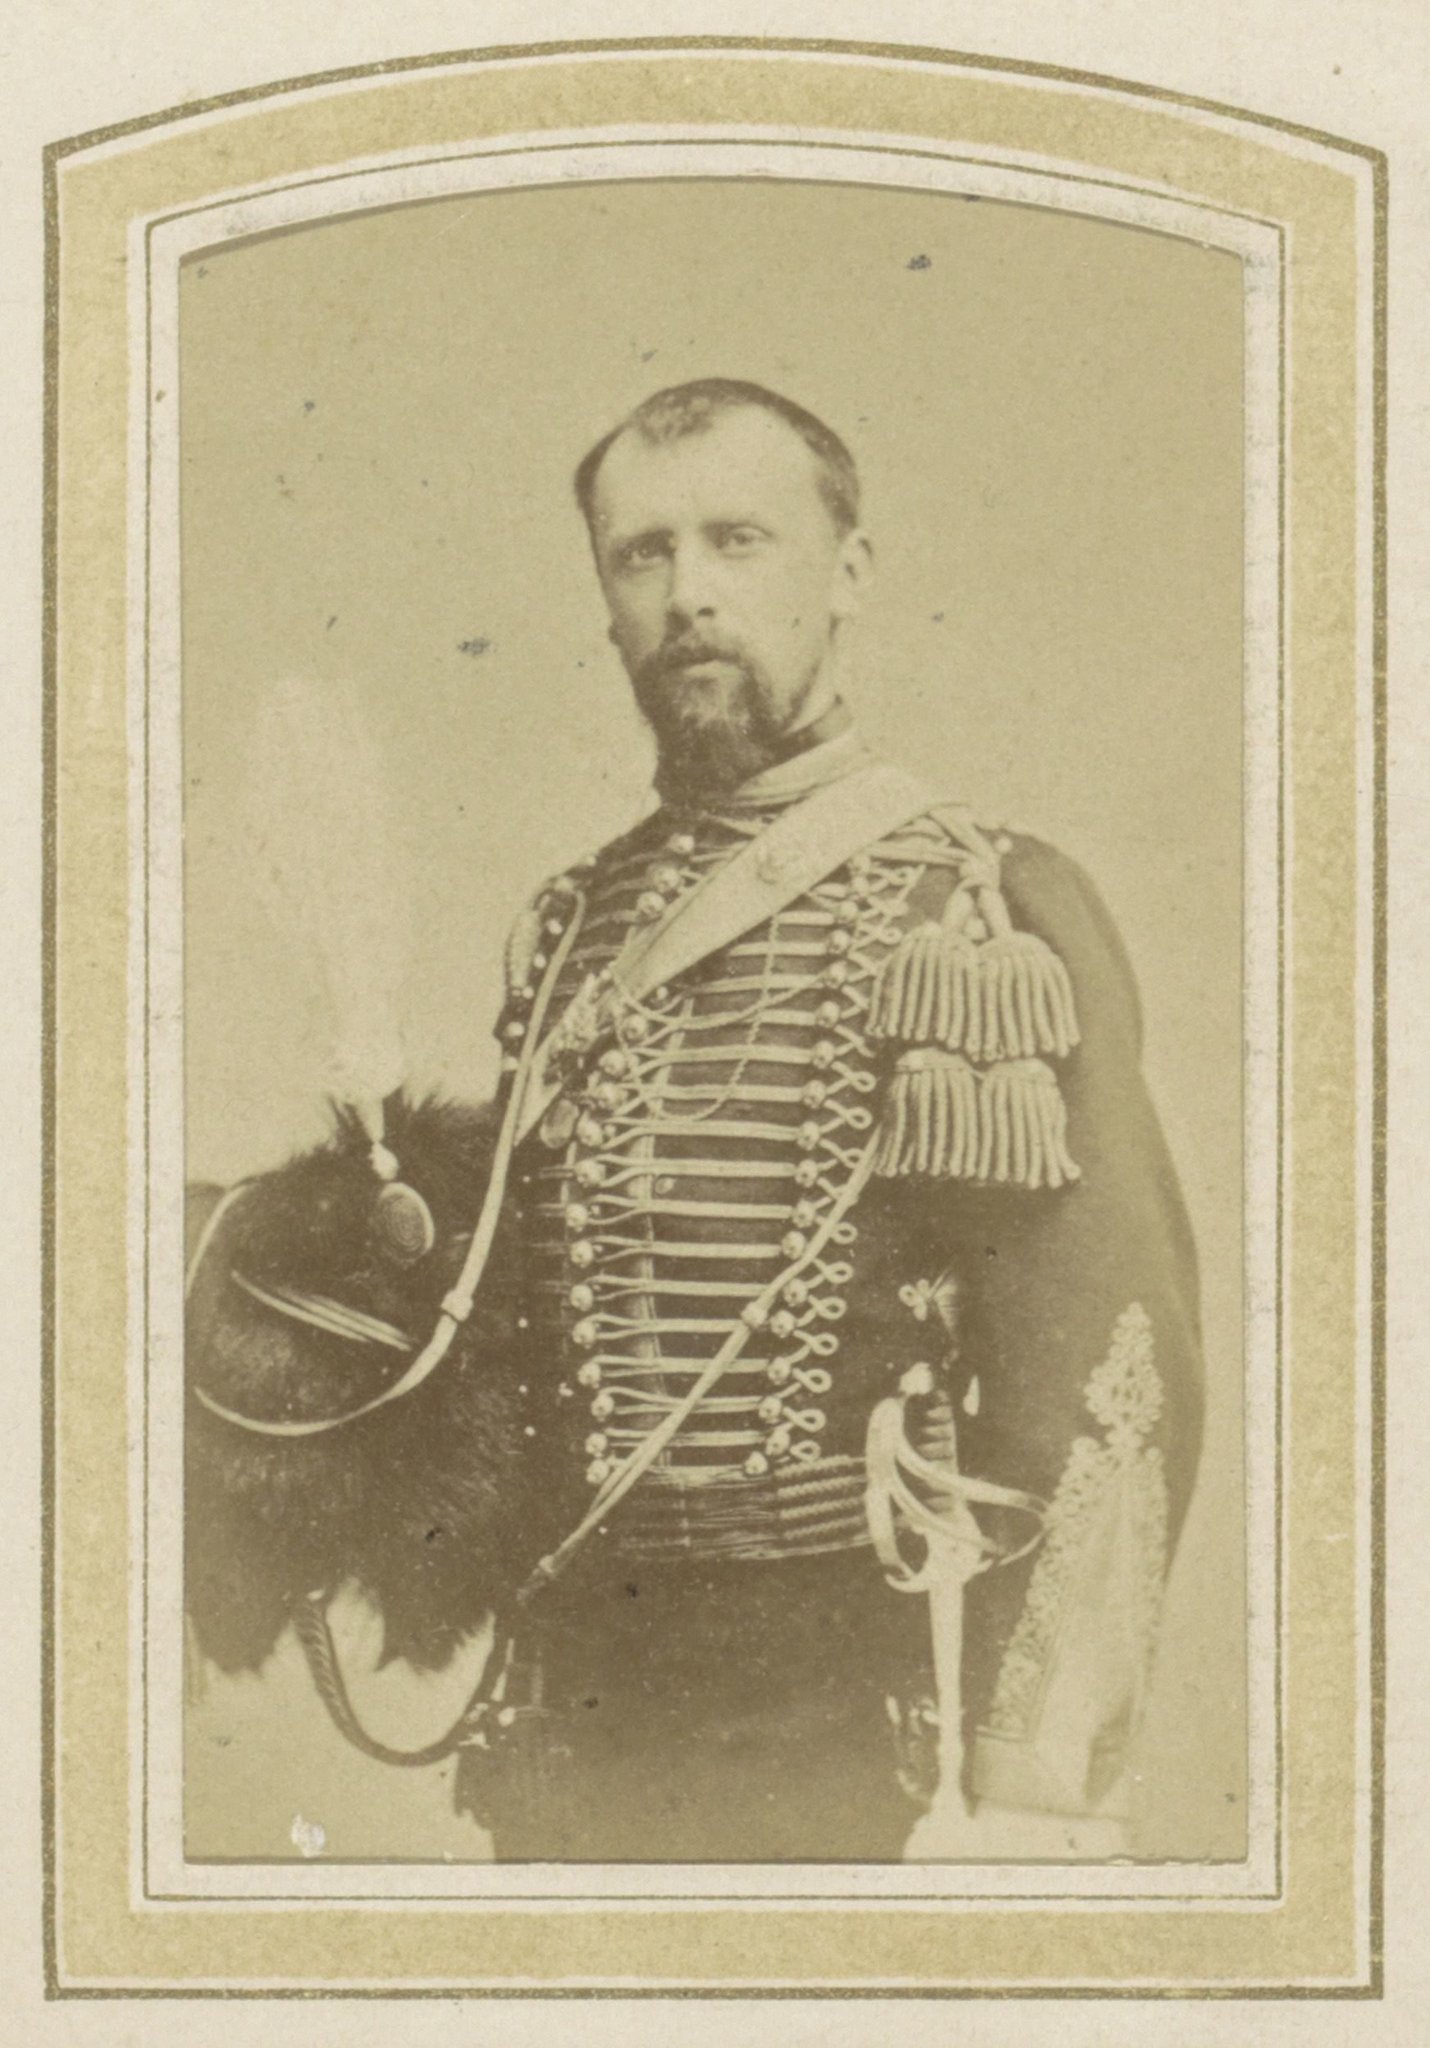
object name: carte de visite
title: Portret van Willem van Oranje-Nassau (Wiwill) in militair uniform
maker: Anonymous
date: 1860-1879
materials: cardboard, paper, photographic support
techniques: albumen print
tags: the hague, willem (prins der nederlanden), head-gear, hacking and thrusting weapons (with name), other persons of royal blood, moustache, historical persons, (military) uniforms, beard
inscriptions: name: ‘Kronprinz v. Holland’, negative number: ‘1175’, stamp: ‘P.’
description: Onderdeel van Fotoalbum van een Nederlandse familie met 168 cartes-de-visite en kabinetfoto's.